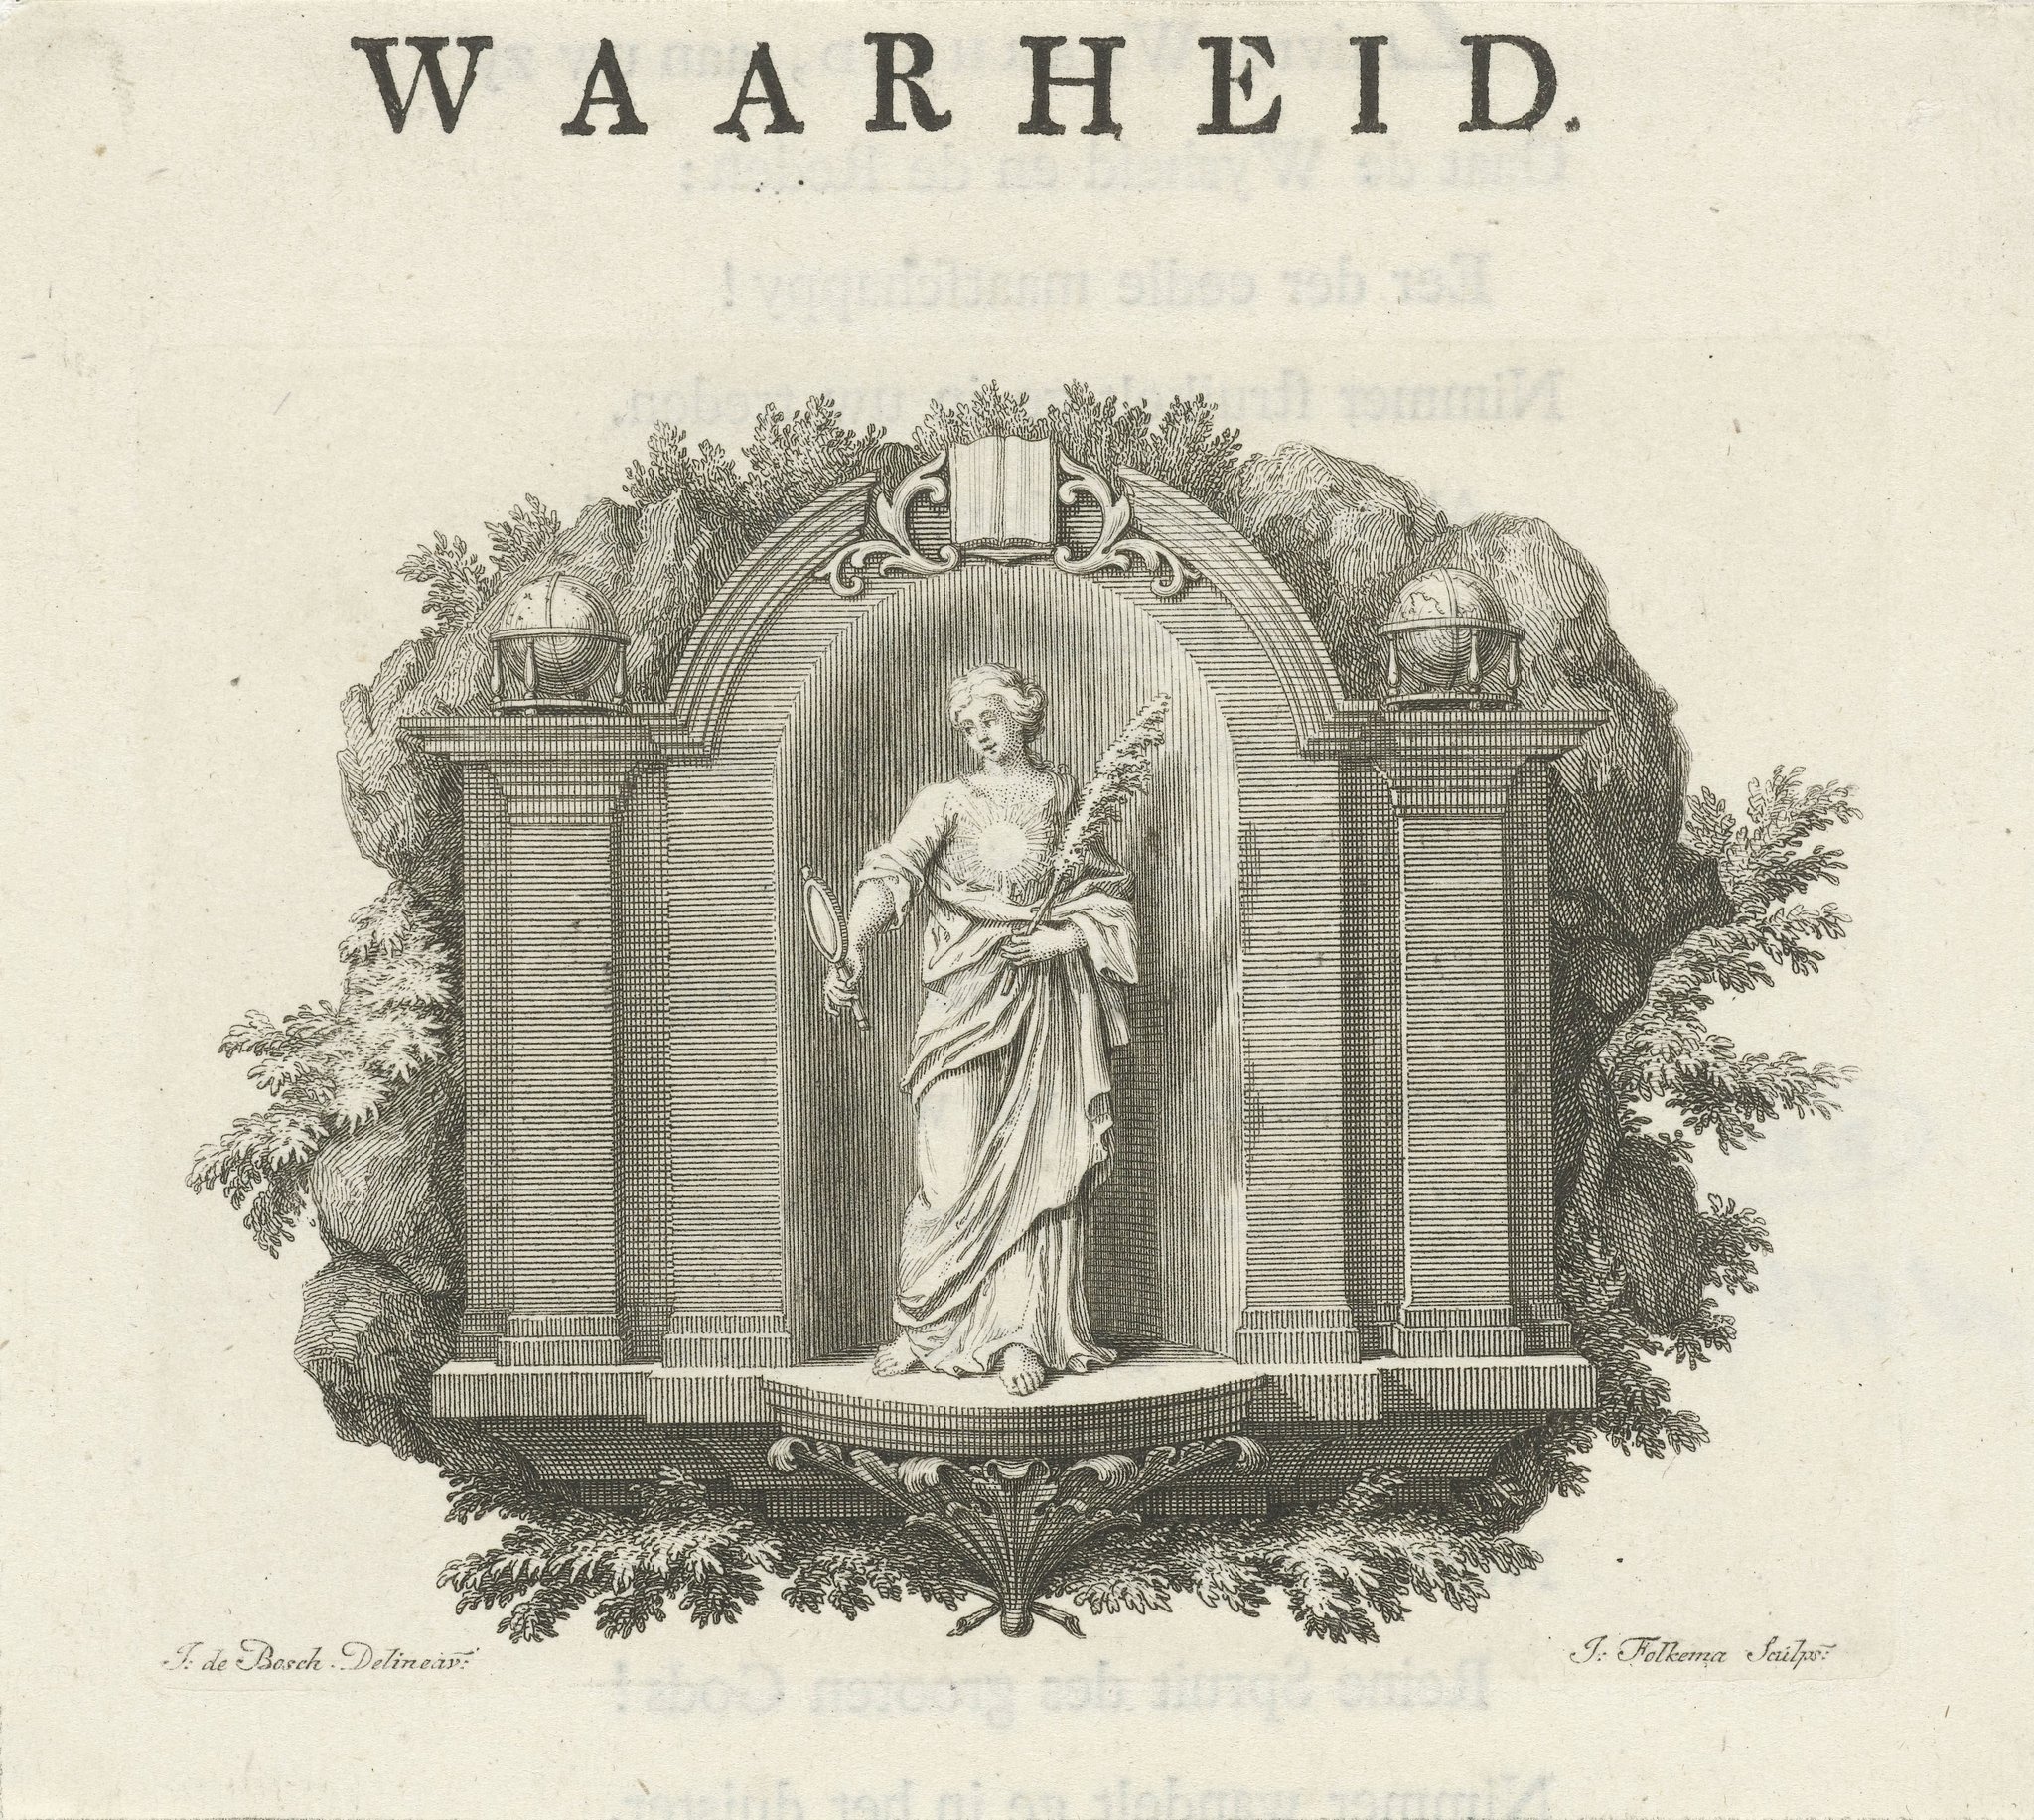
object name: print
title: Vignet met de personificatie van Waarheid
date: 1723-1767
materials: paper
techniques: etching, letterpress printing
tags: truth; 'verità' (ripa)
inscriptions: collector's mark: Lugt 2228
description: Vignet met de beeltenis van de gepersonifieerde Waarheid in een architecturale omlijsting waarin een open boek en twee globes zijn verwerkt. De Waarheid houdt een spiegel en een tak met bladeren in haar handen, op haar borst staat de zon in de vorm van een stralende schijf afgebeeld. De prent maakt deel uit van een reeks boekillustraties over deugden en ondeugden.